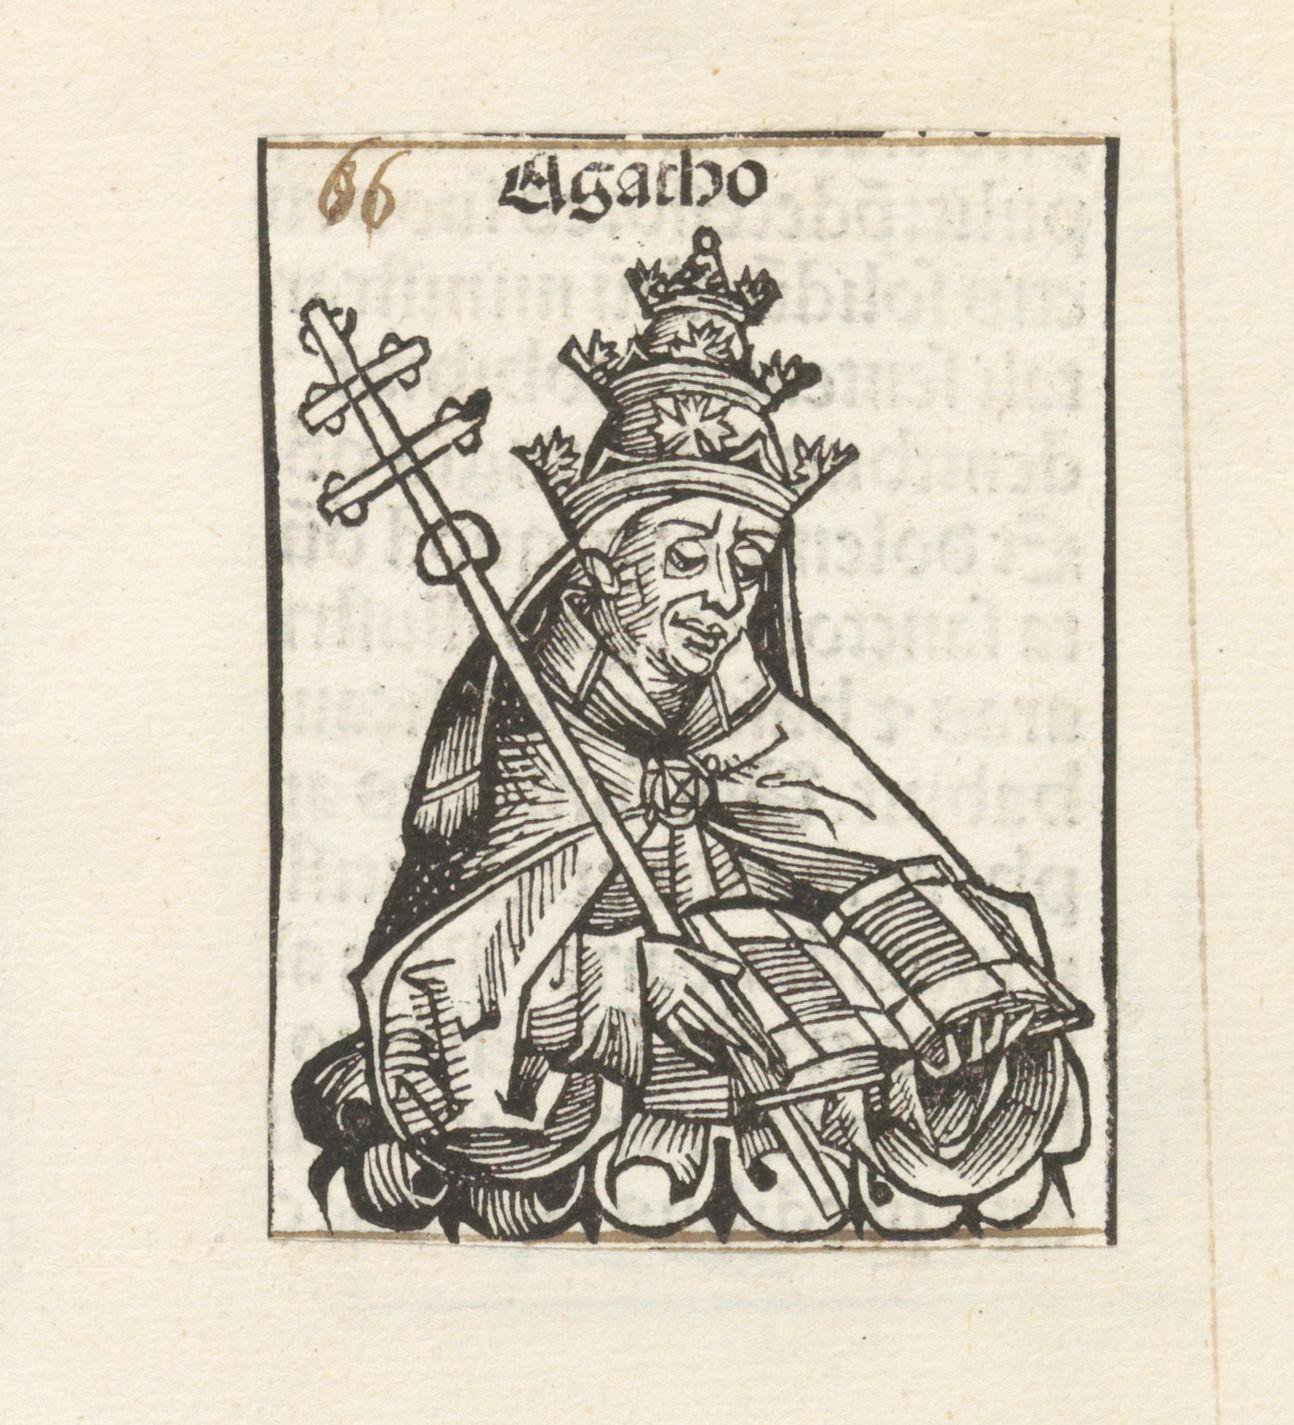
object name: album leaf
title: Paus Agatho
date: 1493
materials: paper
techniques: letterpress printing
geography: nuremberg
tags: pope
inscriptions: inscription: ‘66’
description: Een bloemkelk met een paus. Hij draagt een tiara en heeft een opengeslagen boek en een staf met een dubbel kruis in zijn handen. De voorstelling is onderdeel van de opeenvolging pausen in de Liber Chronicarum. De tekst identificeert de man als Agatho. De prent maakt deel uit van een album.